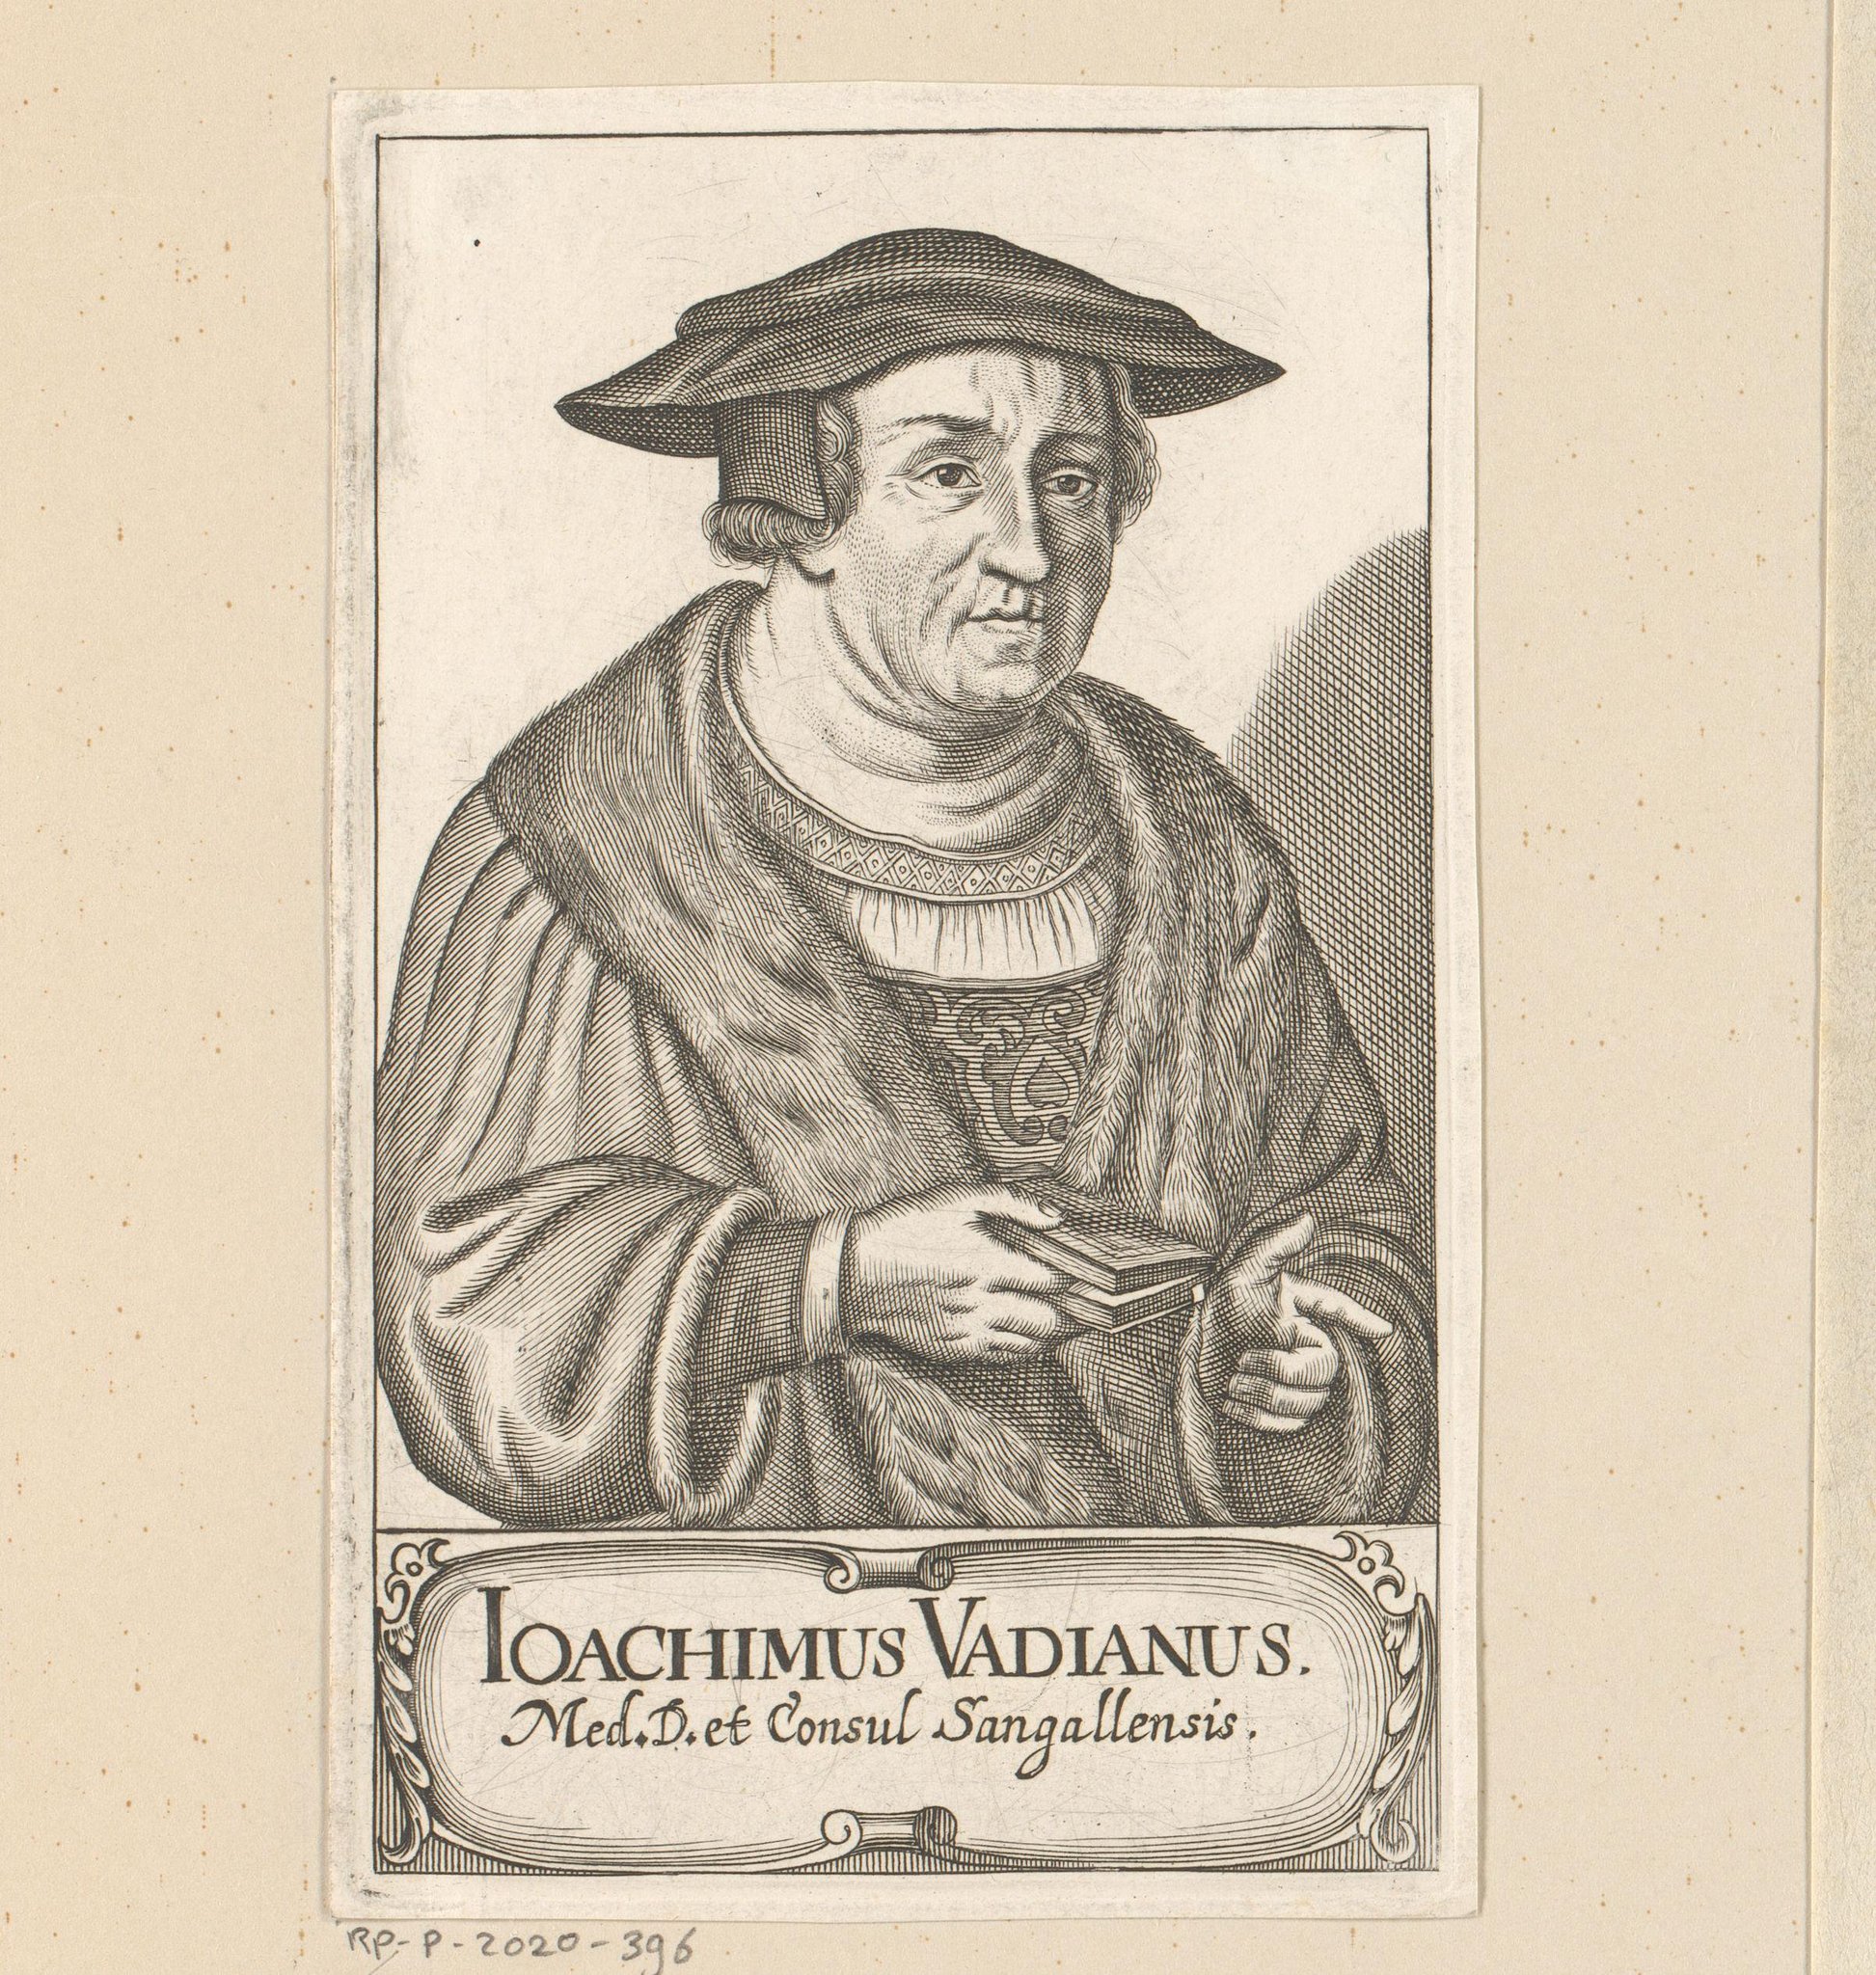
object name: print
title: Portret van Joachim von Watt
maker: Anonymous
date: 1700-1749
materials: paper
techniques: engraving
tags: mayor, historical persons, book